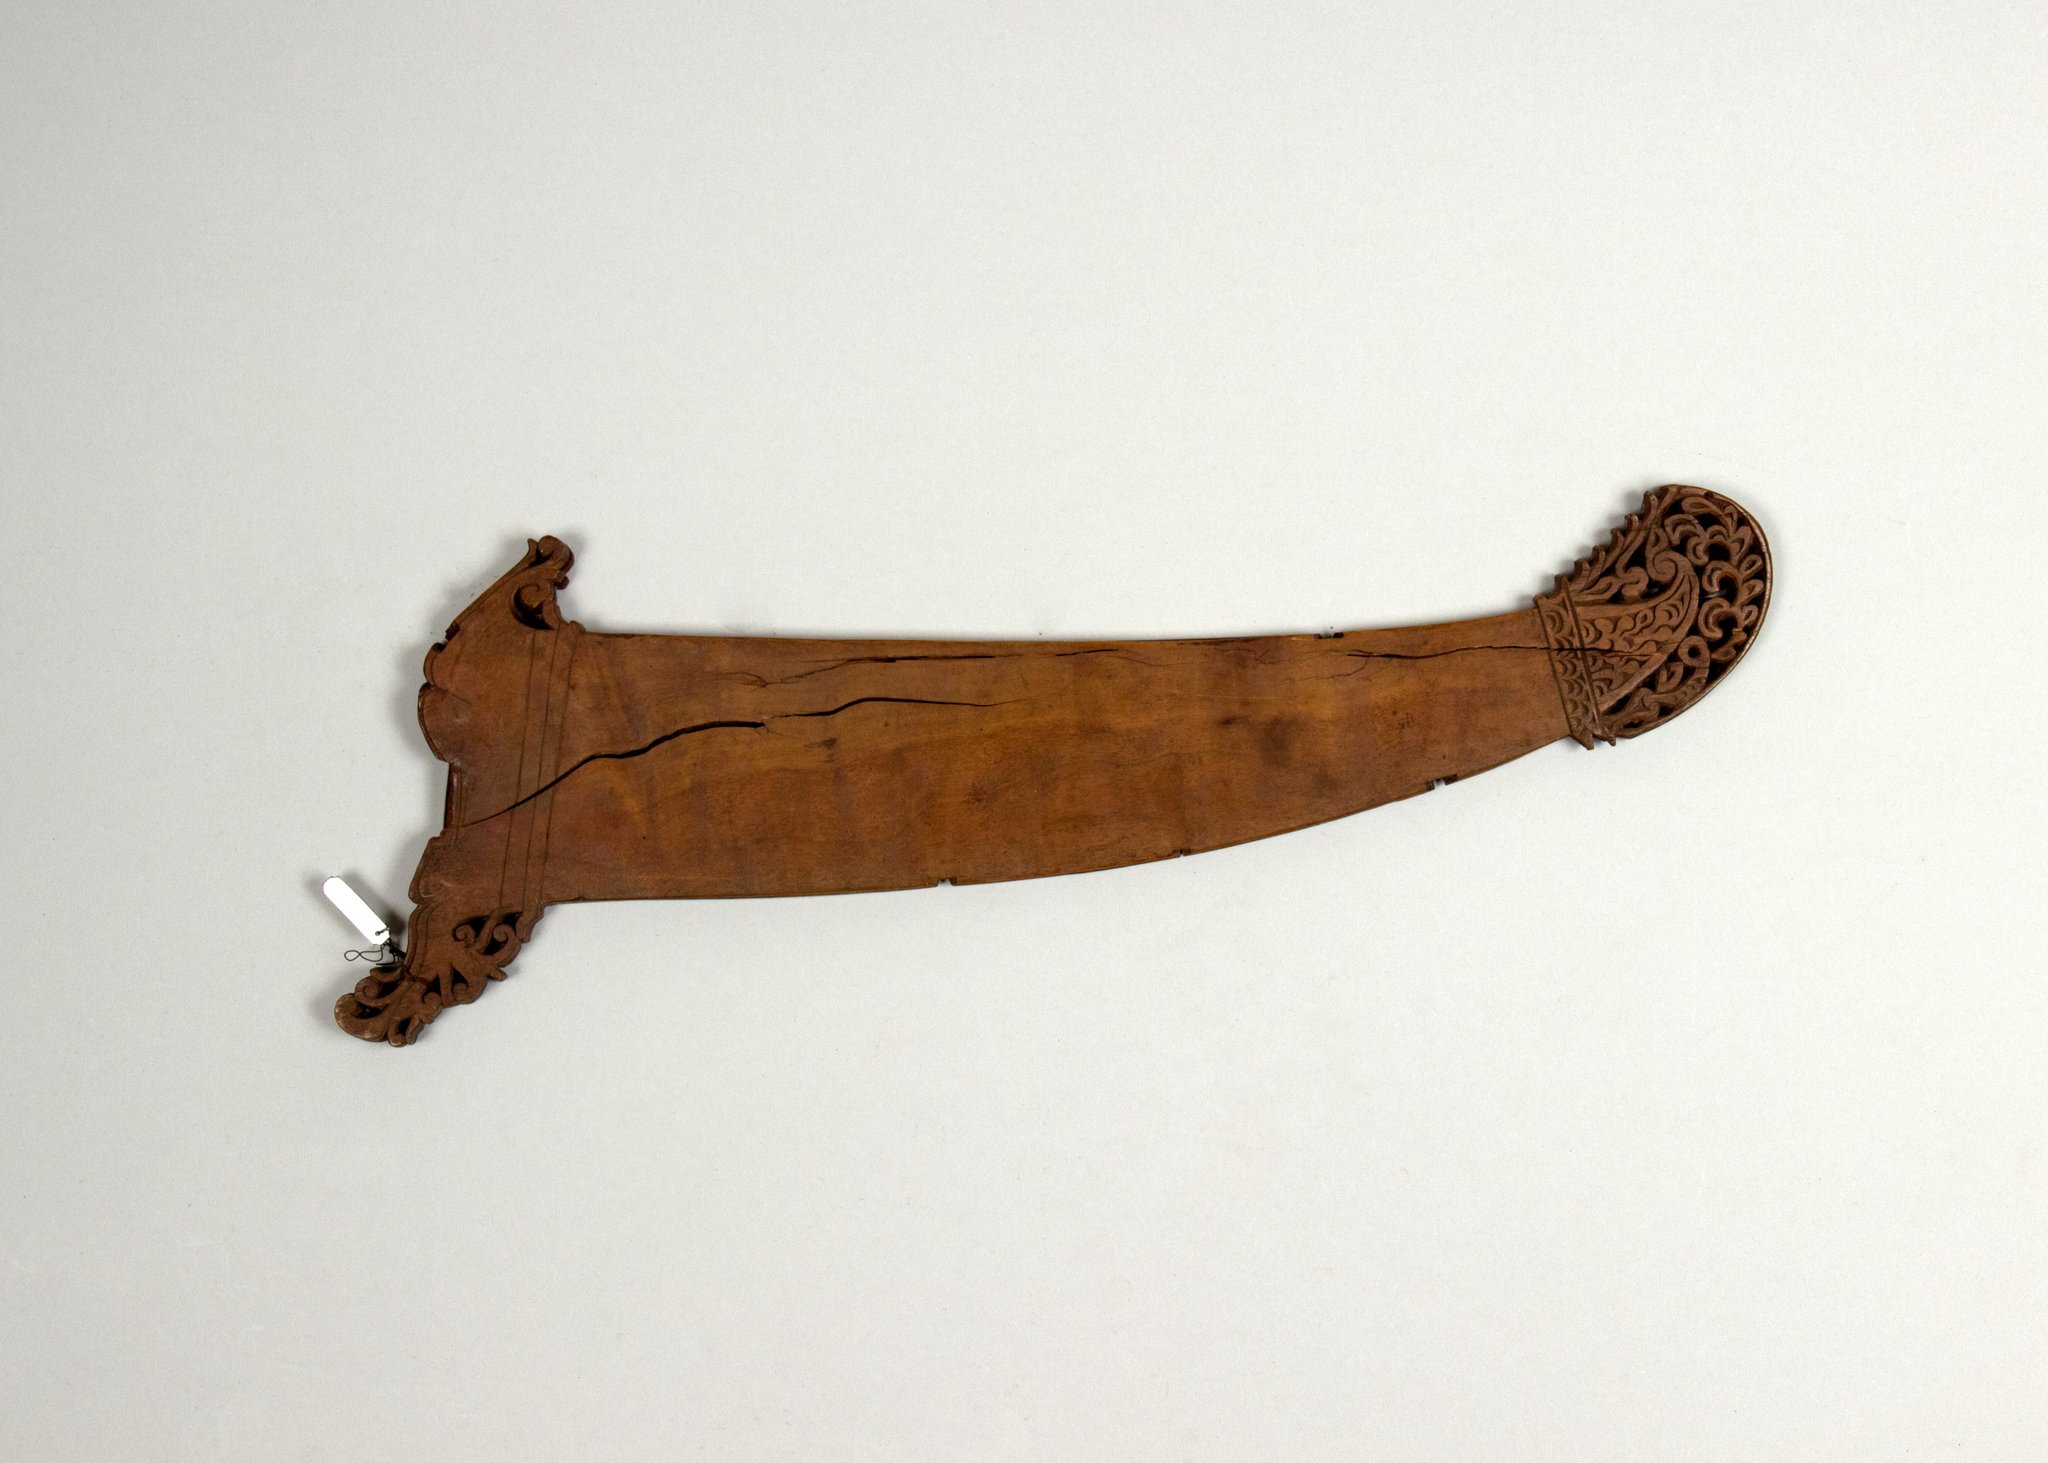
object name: knife with sheath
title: Knife Sheath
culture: filipino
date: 1701-1900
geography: philippines